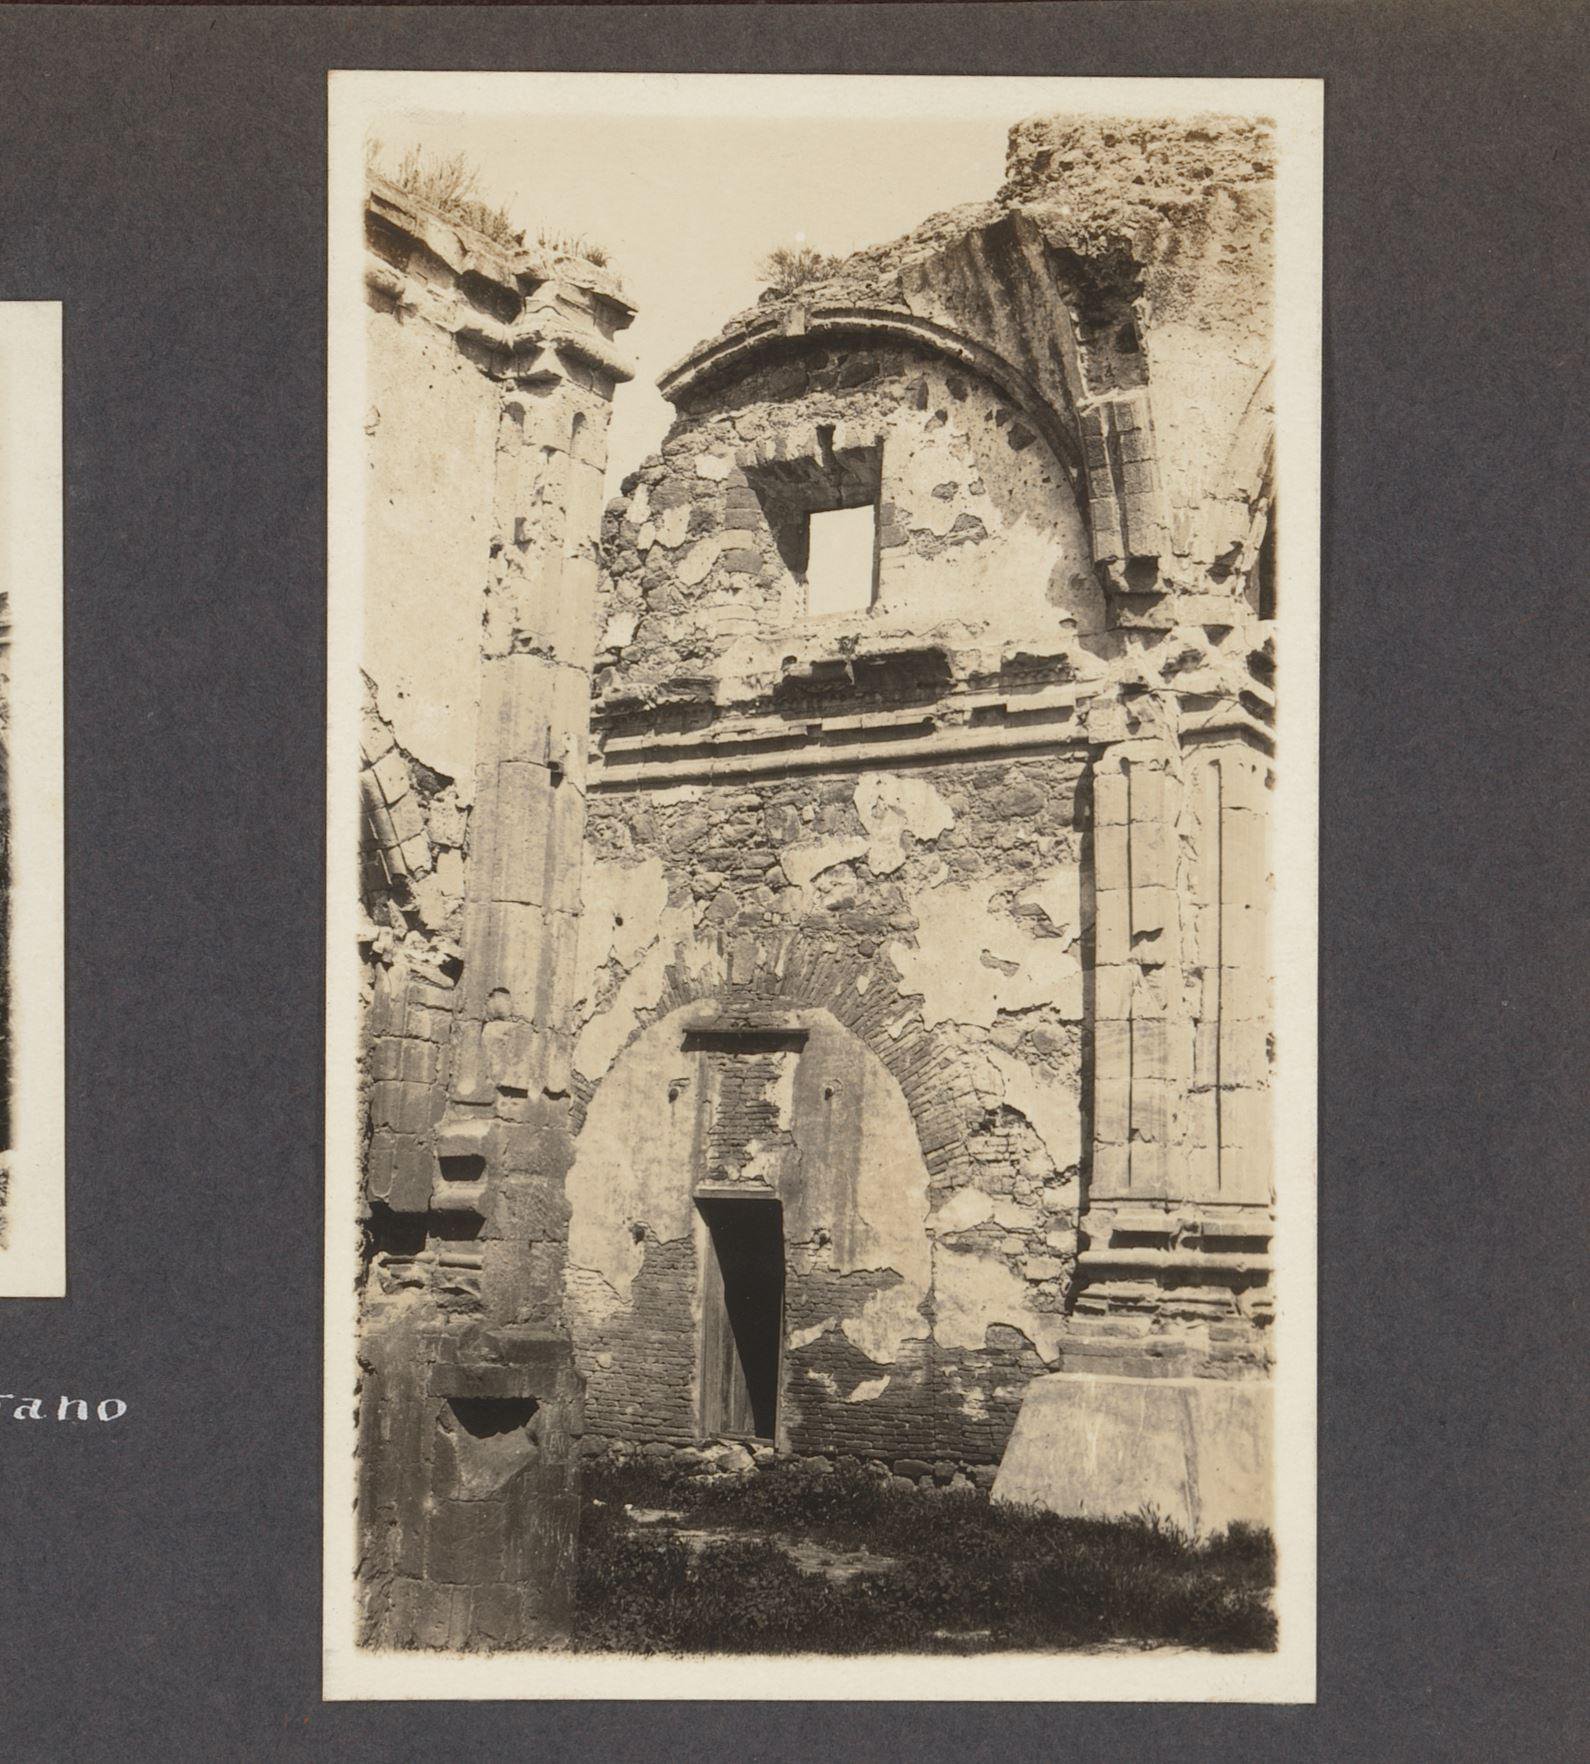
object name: photograph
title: Gezicht op Mission San Juan Capistrano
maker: Anonymous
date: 1928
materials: photographic support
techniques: gelatin silver print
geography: san juan capistrano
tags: trees, civic architecture; edifices; dwellings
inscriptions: annotation: ‘San Juan Capistrano’